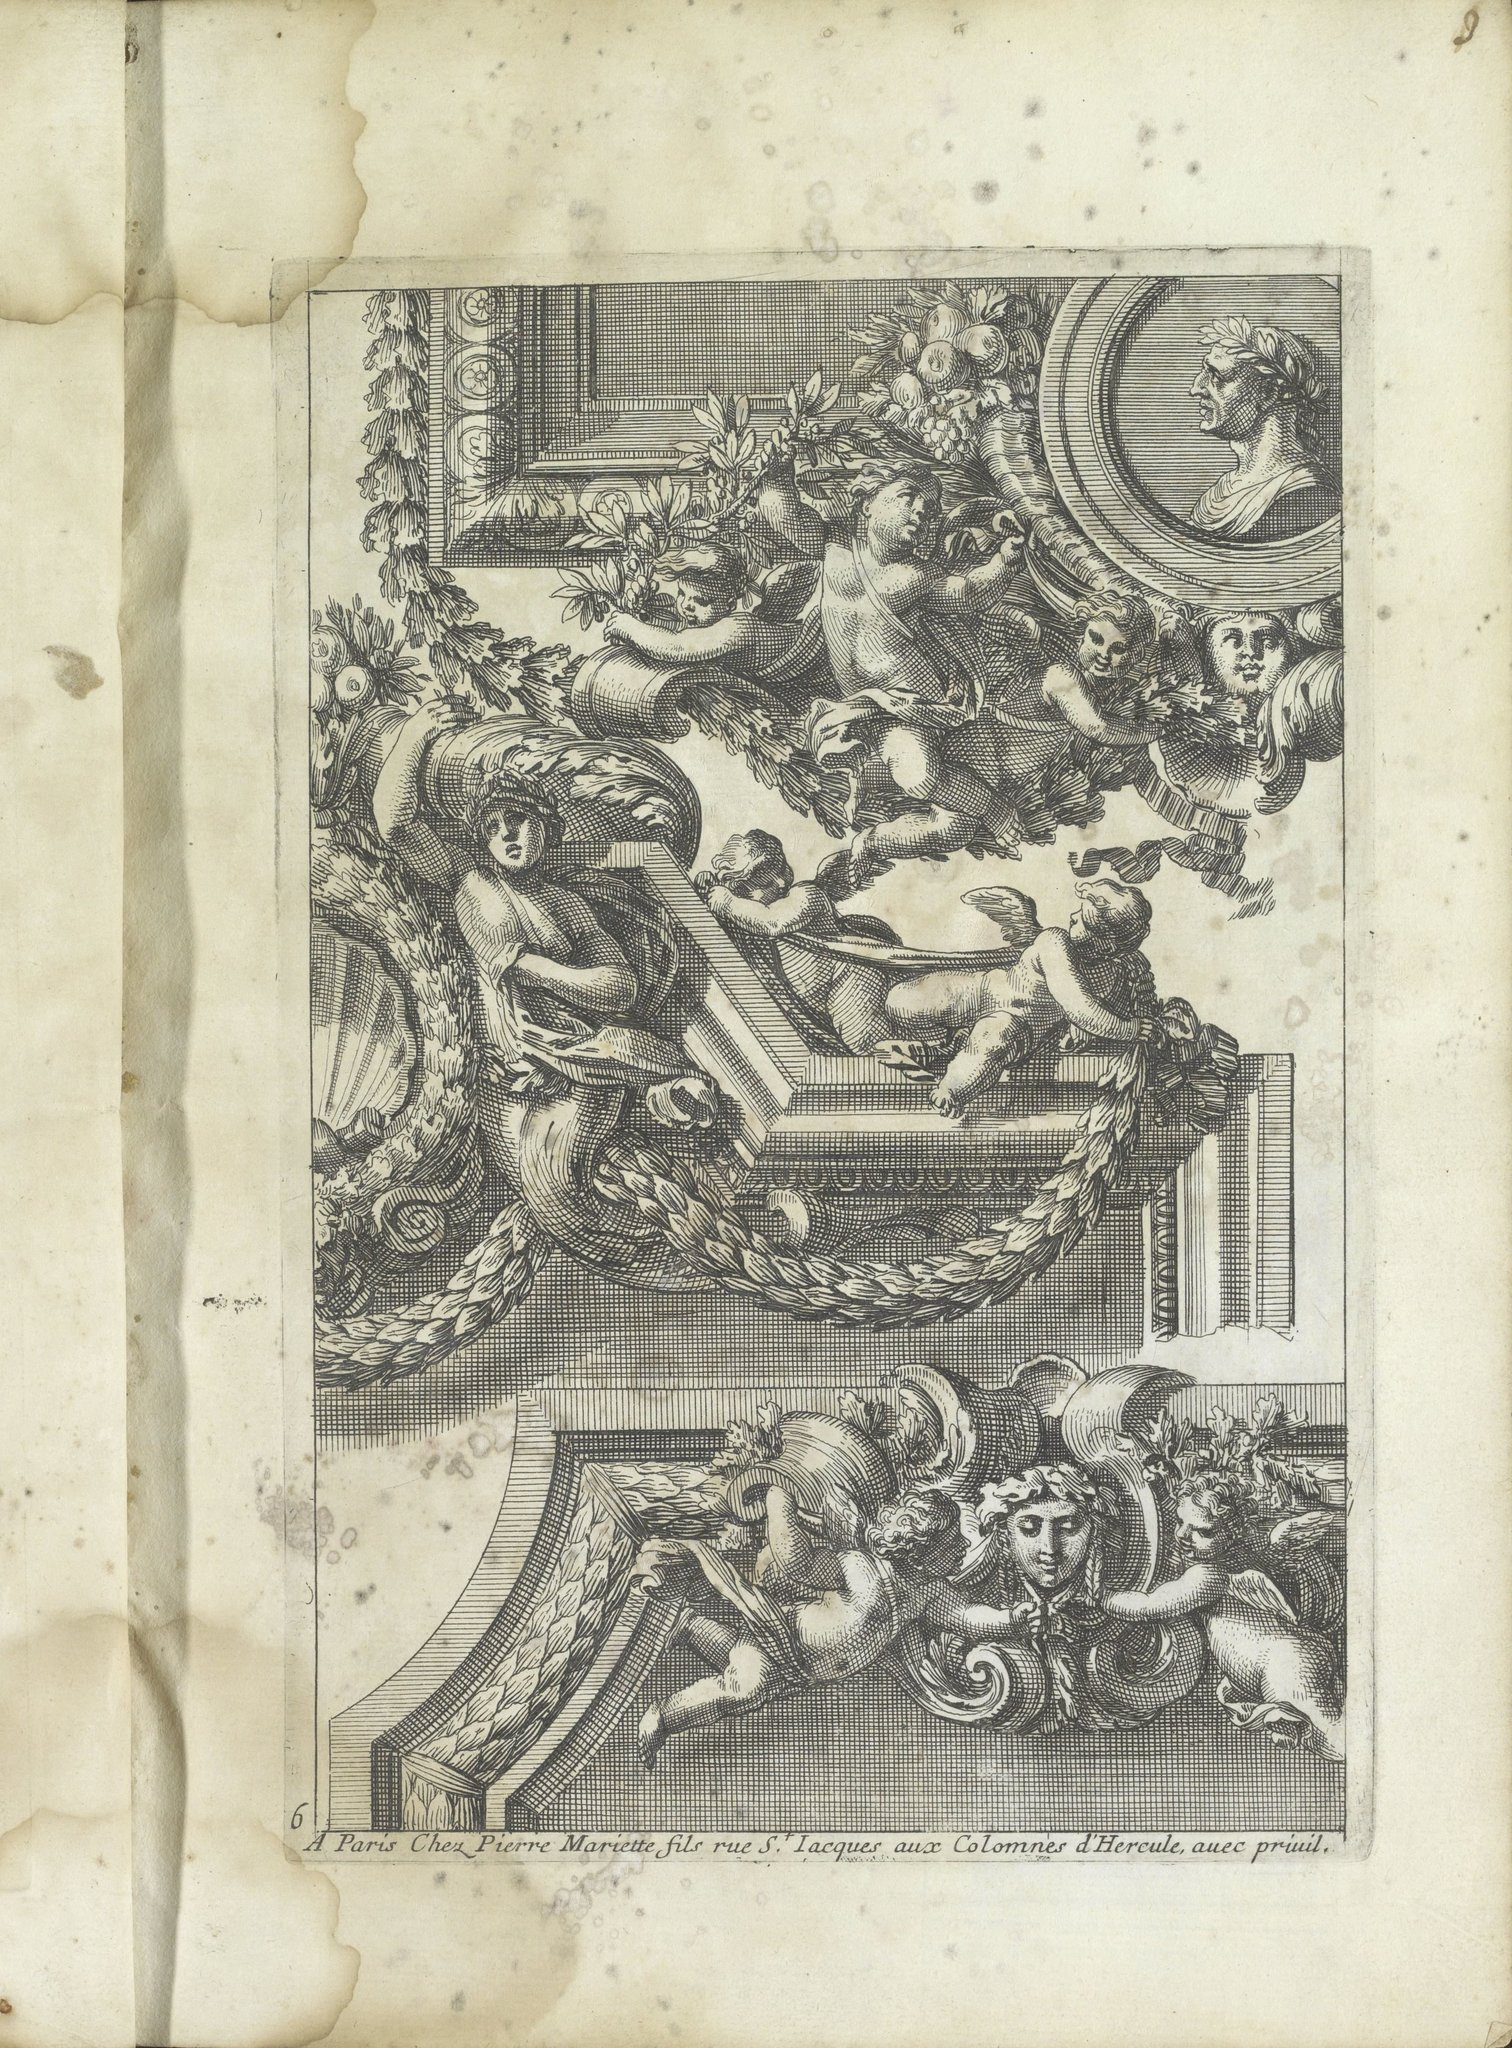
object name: print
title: Drie decoraties voor lijsten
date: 1655-1657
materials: paper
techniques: etching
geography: paris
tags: ornaments ~ art, ornament ~ festoon, garland, cupids: 'amores', 'amoretti', 'putti'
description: Decoraties voor het midden van de boven- of onderkant van lijsten. De bovenste lijst bevat een medaillon met de buste van een keizer. Prent maakt deel uit van een album.